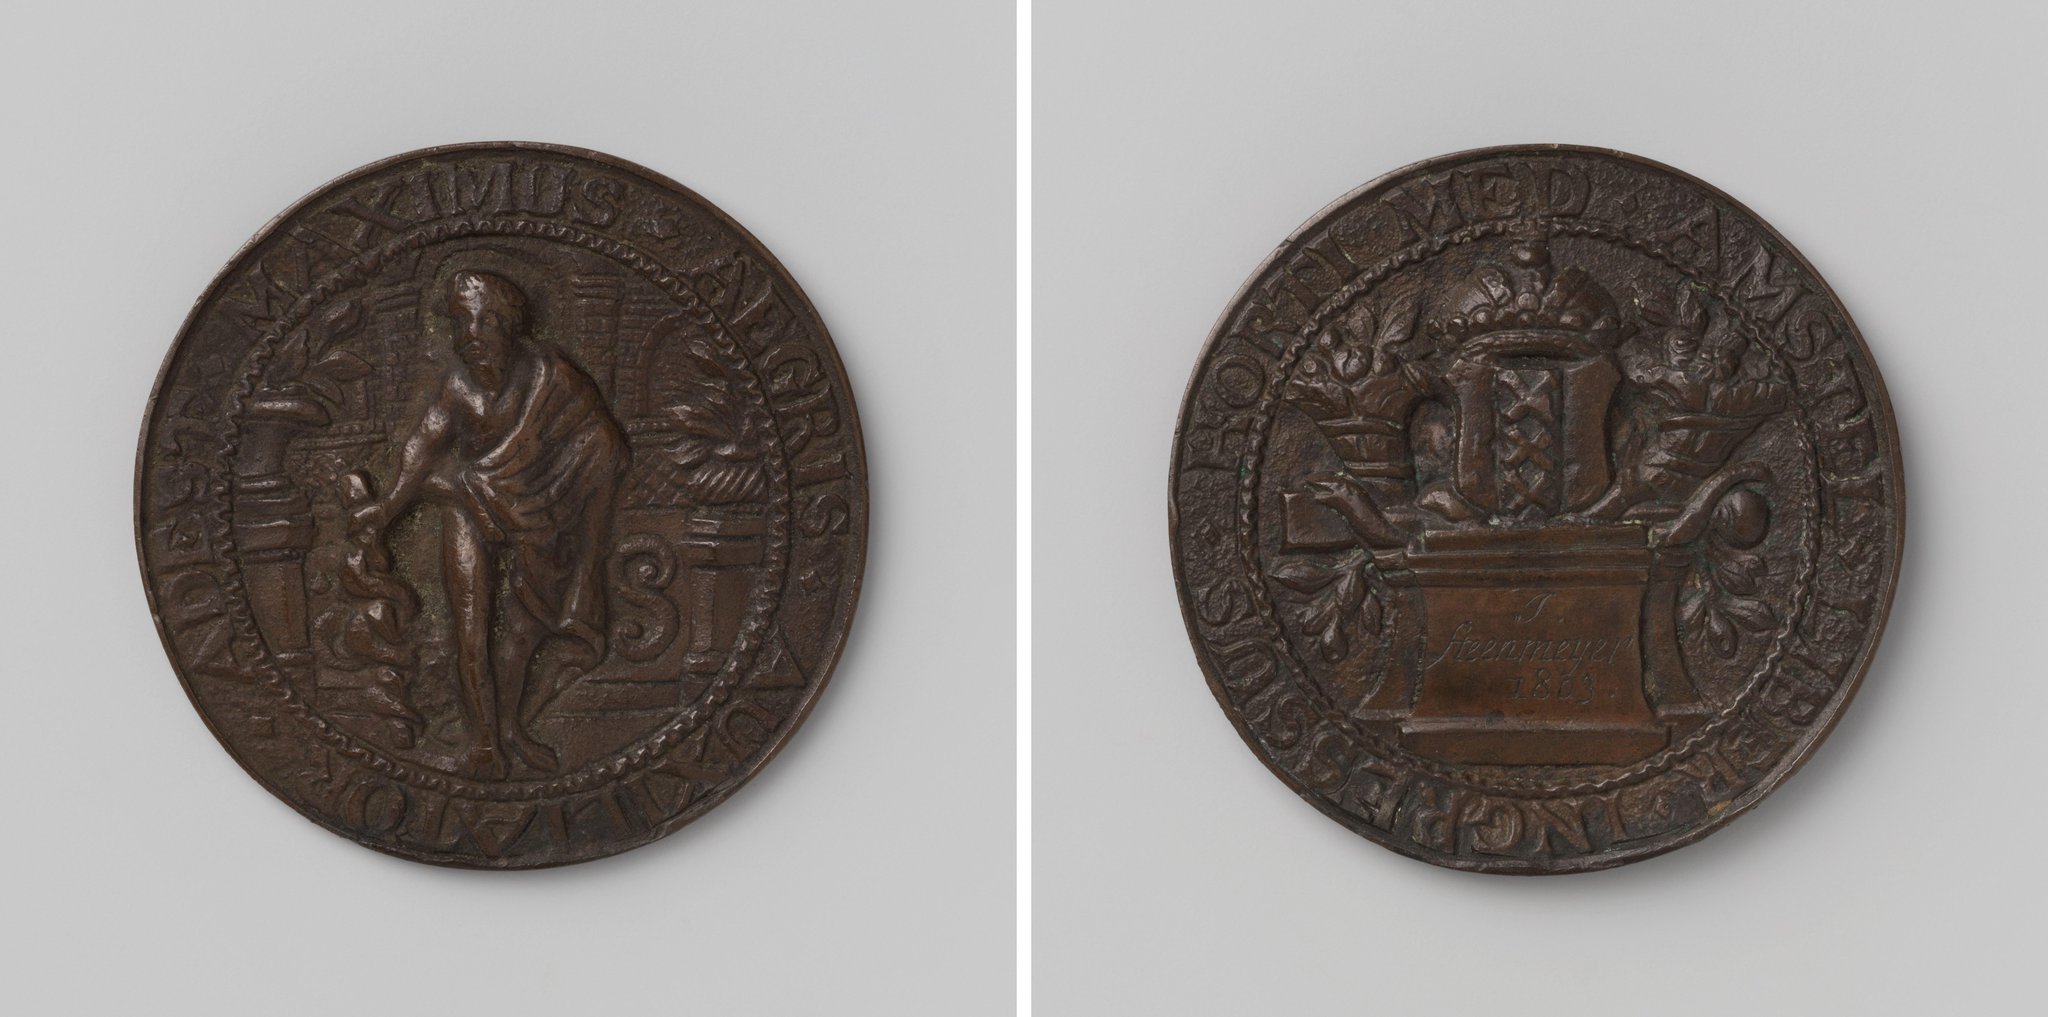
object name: medal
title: Collegium Medicum te Amsterdam, toegangspenning voor de hortus medicus van J. Steenmeyer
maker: willem de wijs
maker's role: medailleur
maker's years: 1700-1795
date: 1803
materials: copper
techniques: casting, engraving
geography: amsterdam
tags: j. steenmeyer, hortus medicus, collegium medicum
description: Koperen penning. Voorzijde: Aesculapius met rechterhand leunend op slangestaf en linkerhand onder zijn mantel, staande tussen twee vazen met planten op voetstuk; op achtergrond wand van gebouw binnen omschrift. Keerzijde: gekroond wapenschild tussen twee gevulde hoorns van overvloed boven zalfspatel, waarom slang zich kronkelt, liggend op voetstuk met opschrift binnen omschrift